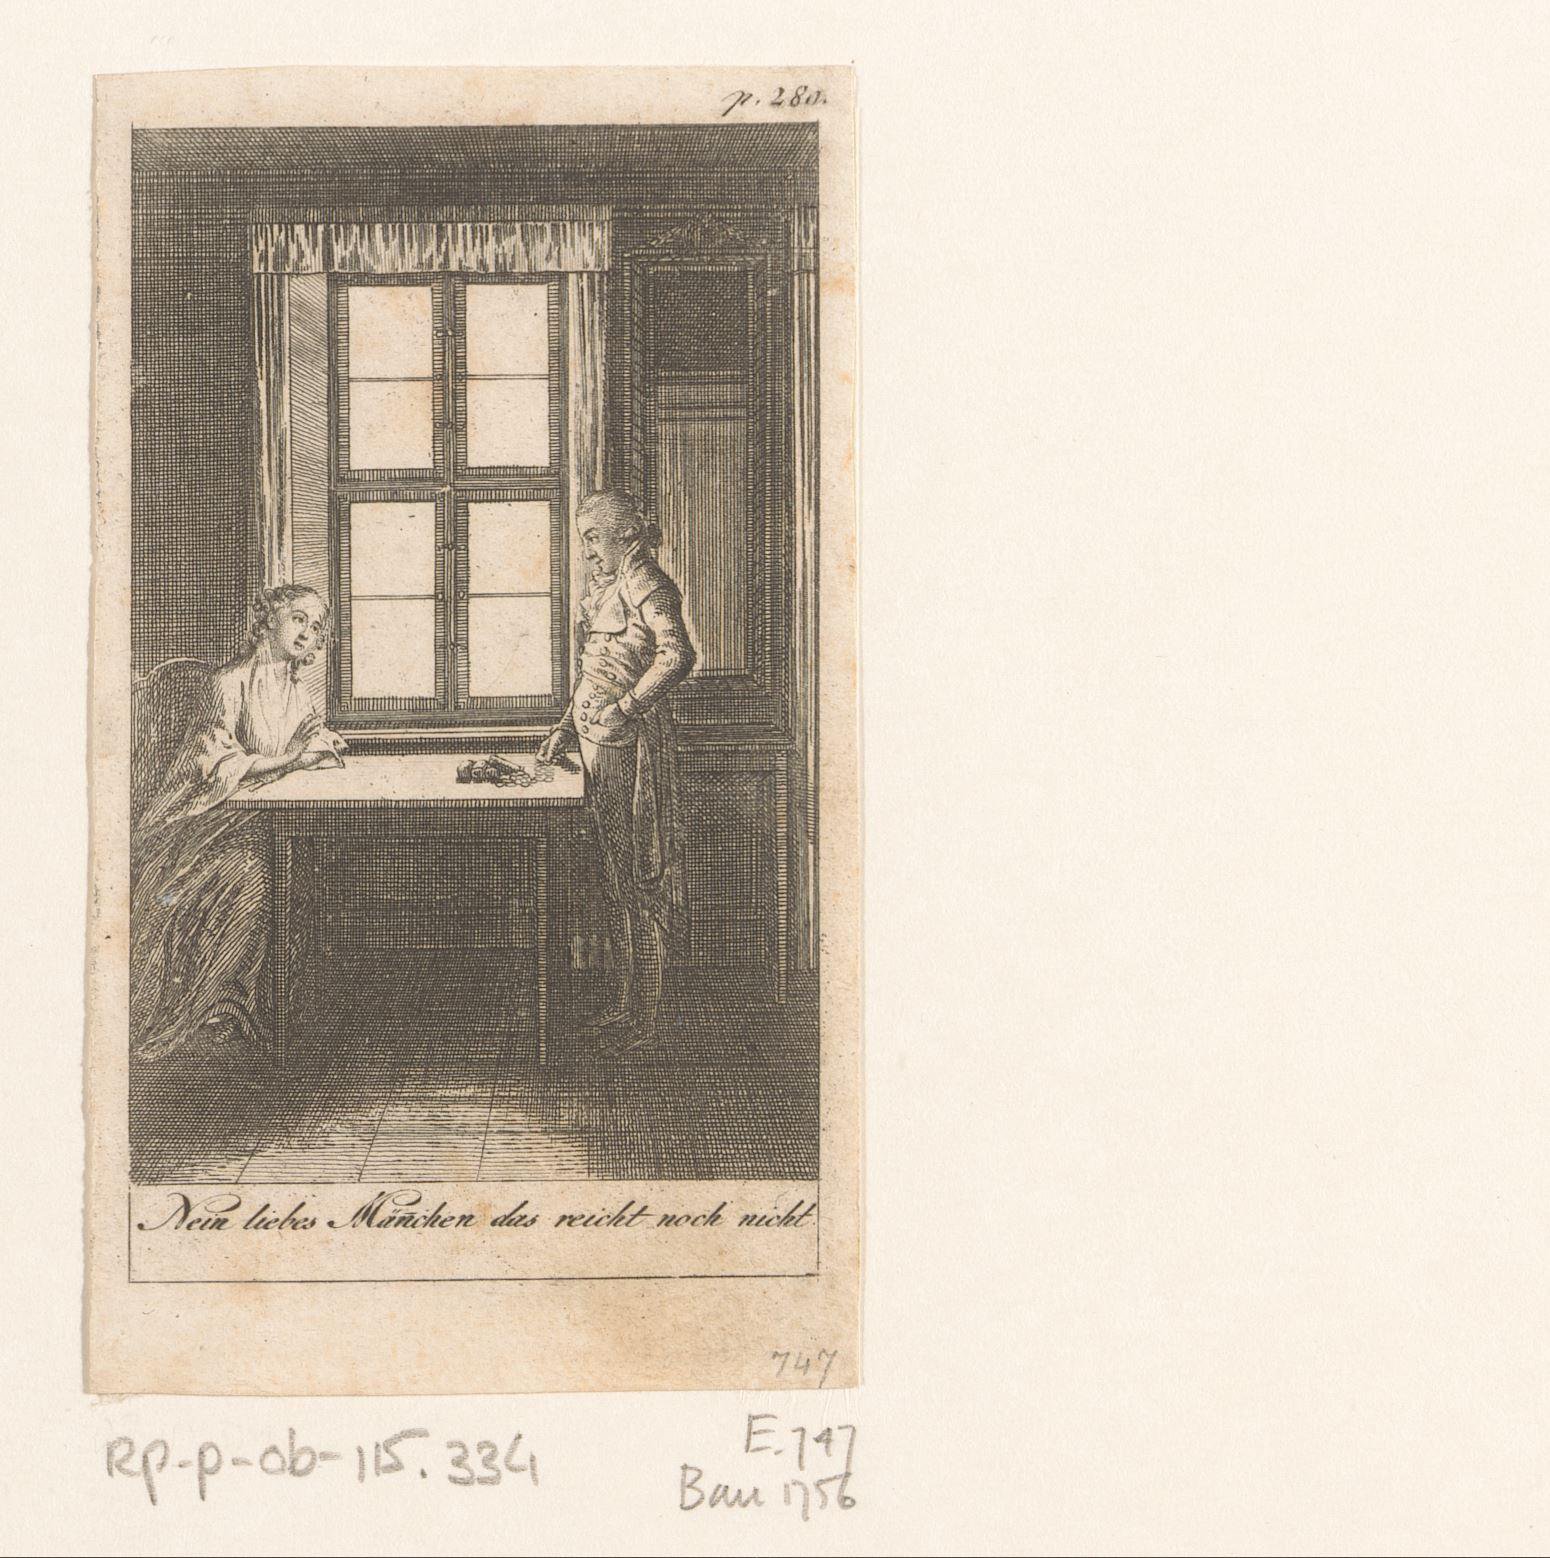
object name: print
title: Charlotte spreekt met haar man over geld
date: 1794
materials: paper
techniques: etching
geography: leipzig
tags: closed window, money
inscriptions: collector's mark: Lugt 2228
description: Prent gebruikt voor: Ehrenberg, Friedrich. Leipziger Taschenbuch für Frauenzimmer zum Nutzen und Vergnügen auf das Jahr 1795. Leipzig: Adam Friedrich Böhme, s.a.